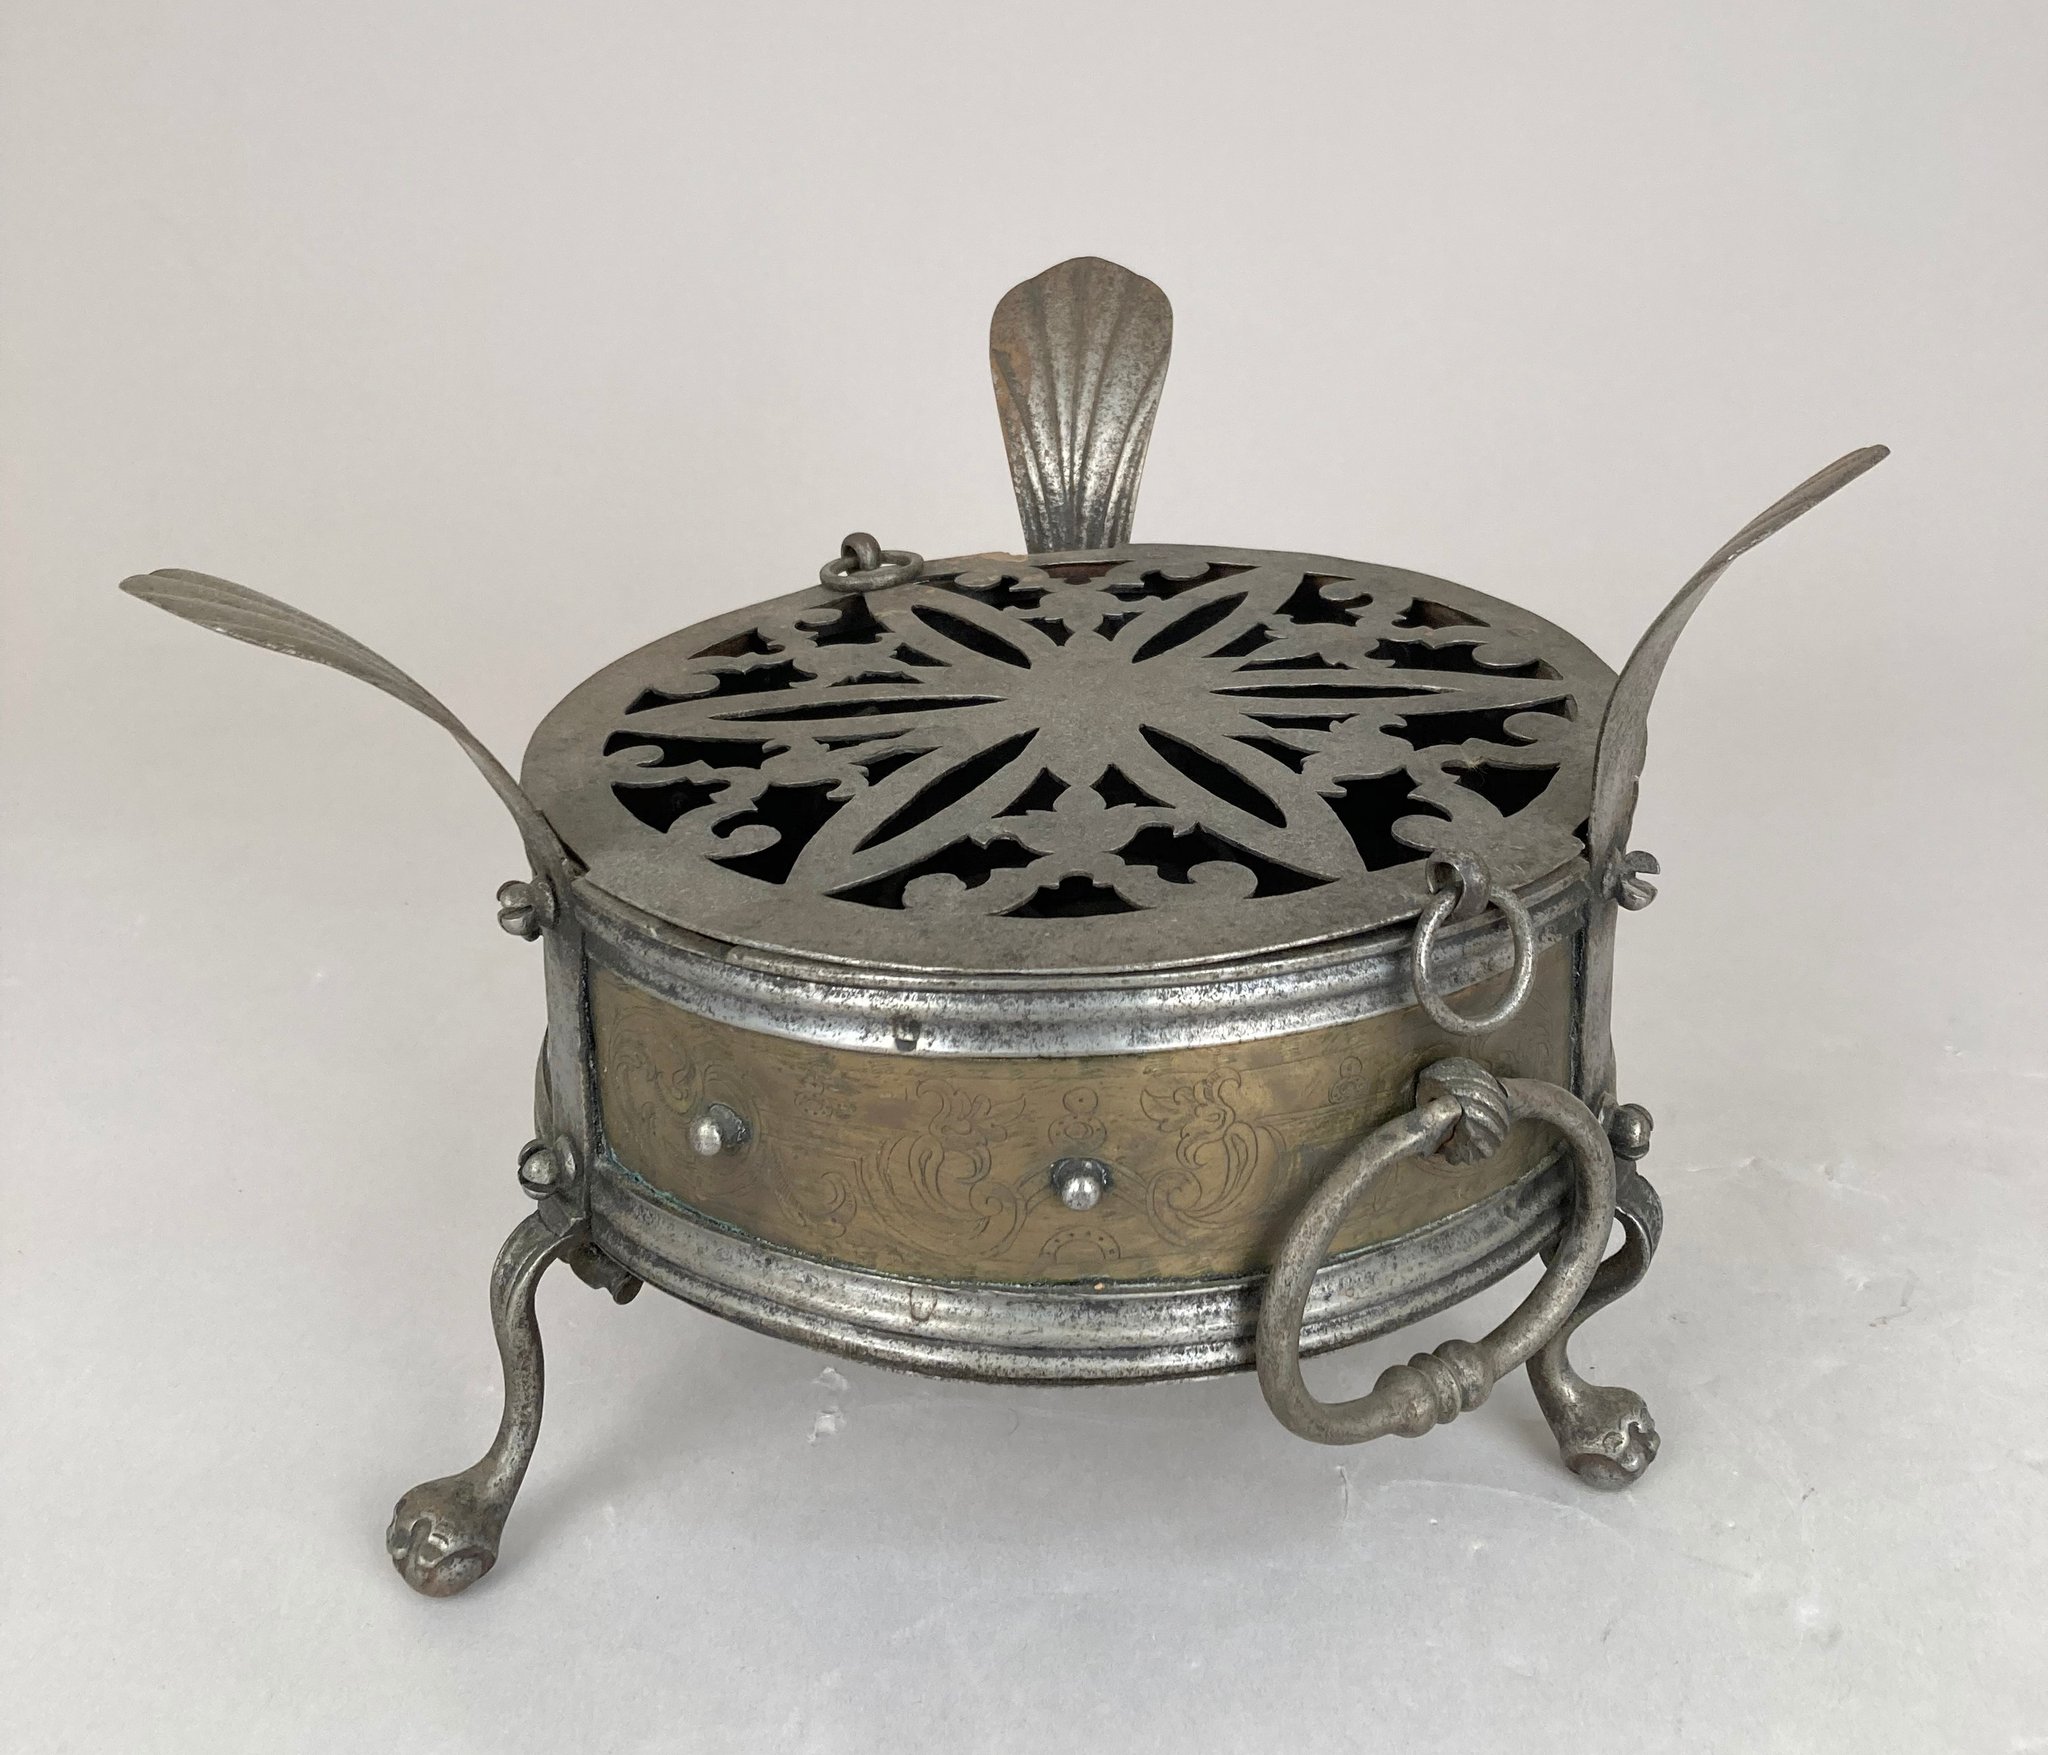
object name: brazier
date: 1601-1700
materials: brass, iron